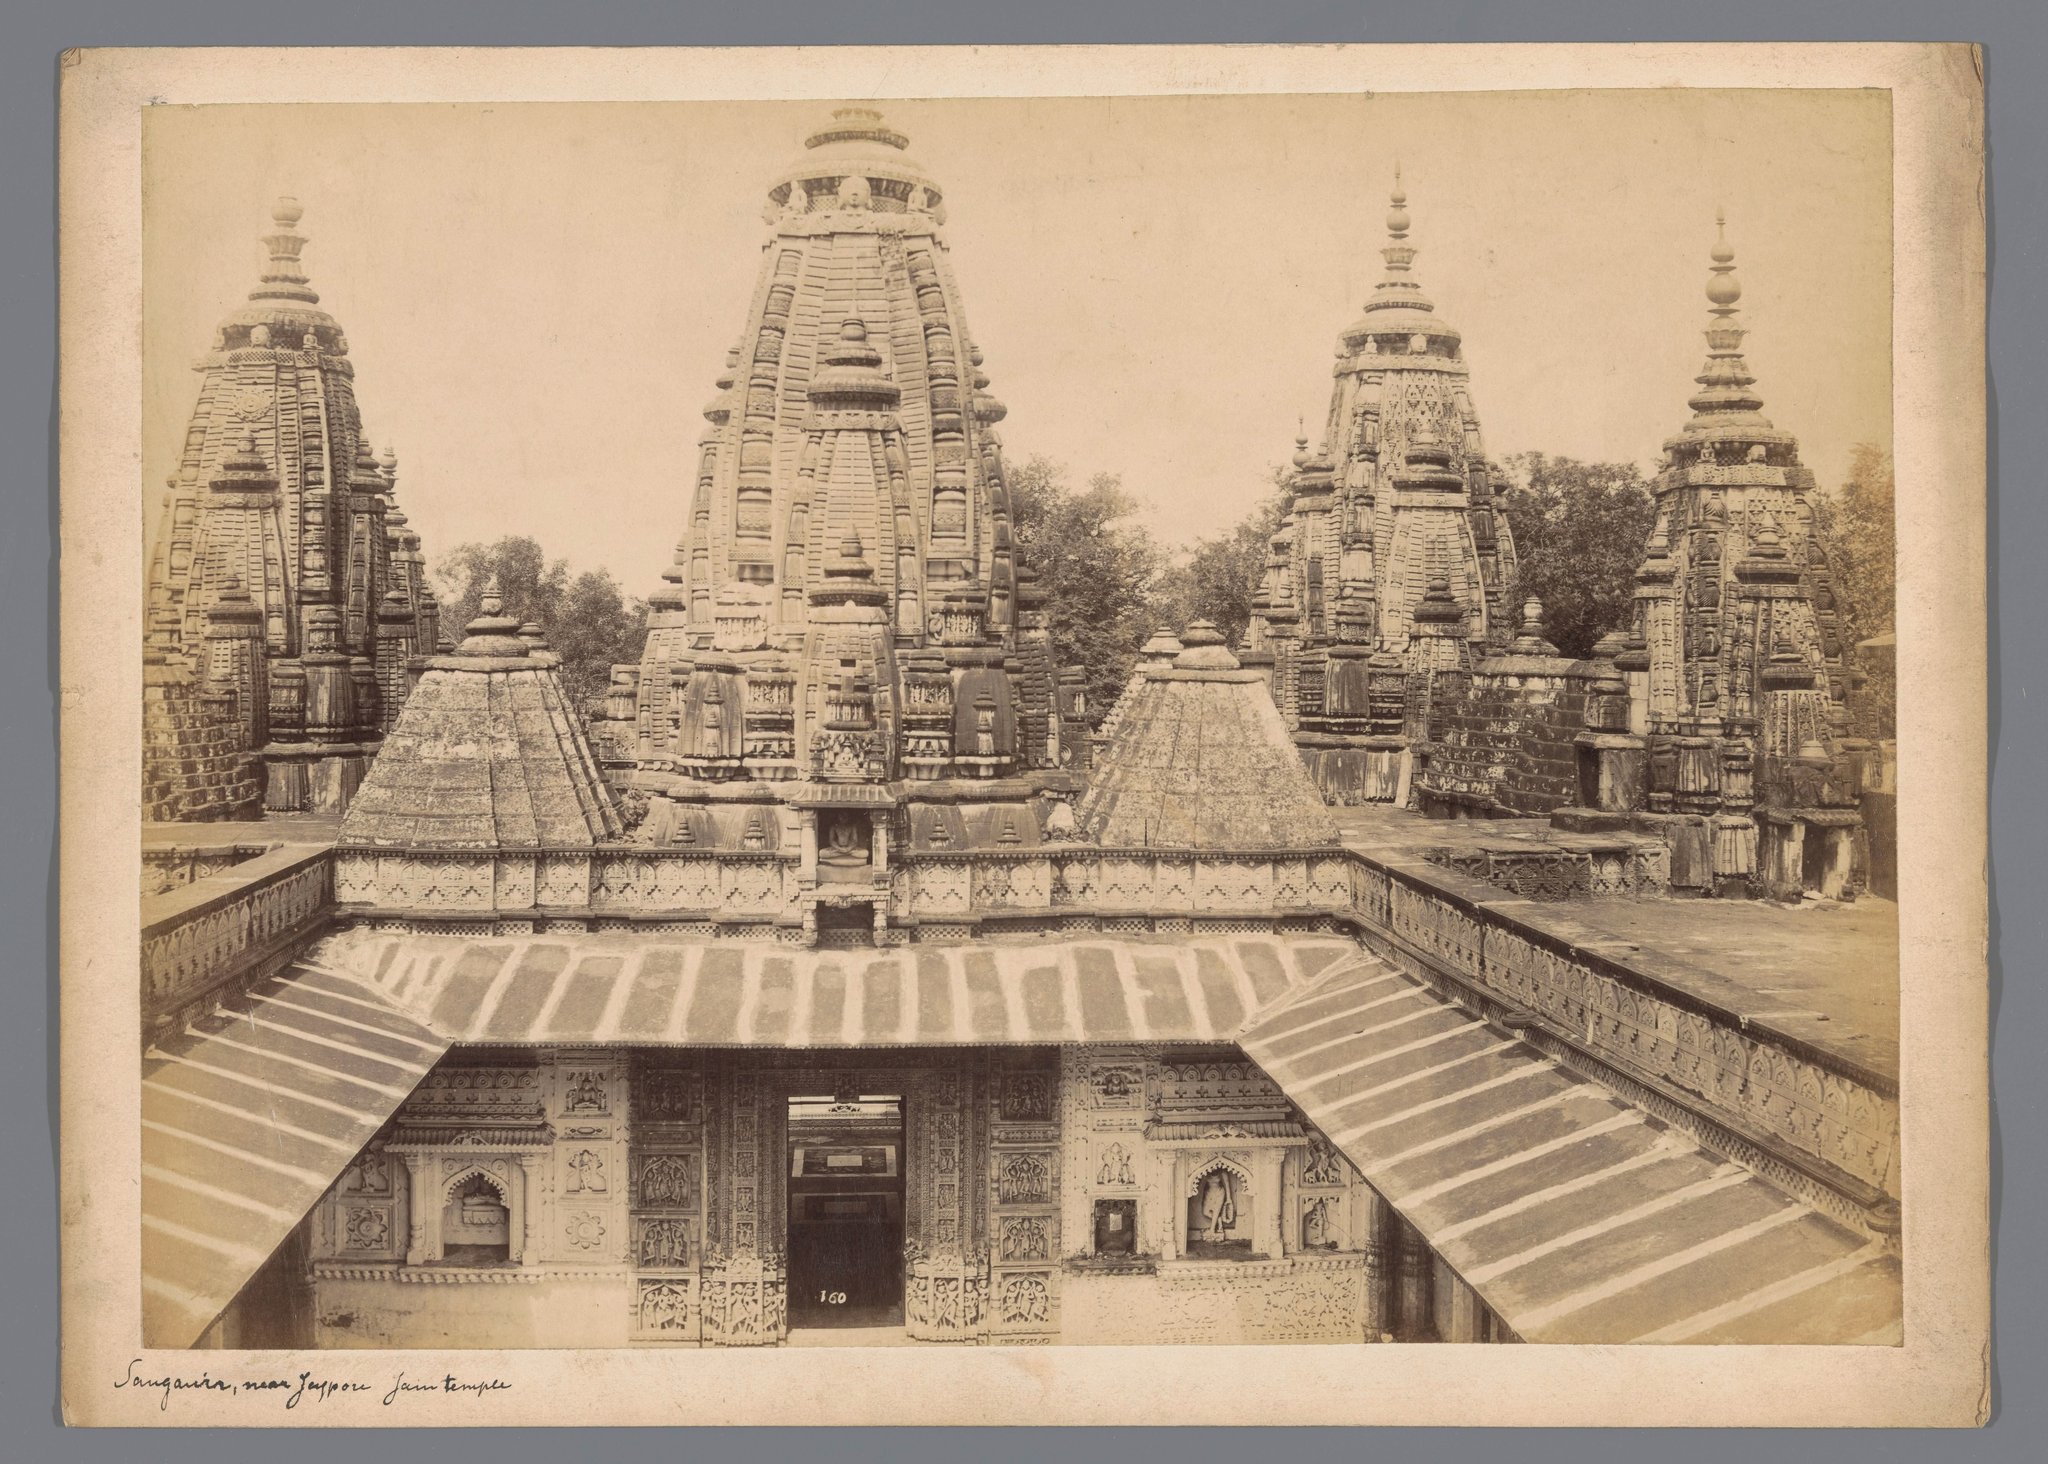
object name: photograph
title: Towers of the Digambar Jain temple in Sanganer near Jaipur, Rajasthan, India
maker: Anonymous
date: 1865-1890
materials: cardboard, paper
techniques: albumen print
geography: sanganer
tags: temple, shrine ~ hinduism, buddhism, jainism, tower, clock tower ~ monumental adornment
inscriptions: number: ‘97’, number: ‘160’, title: ‘Sanganir, near Jeypore Jain temple’